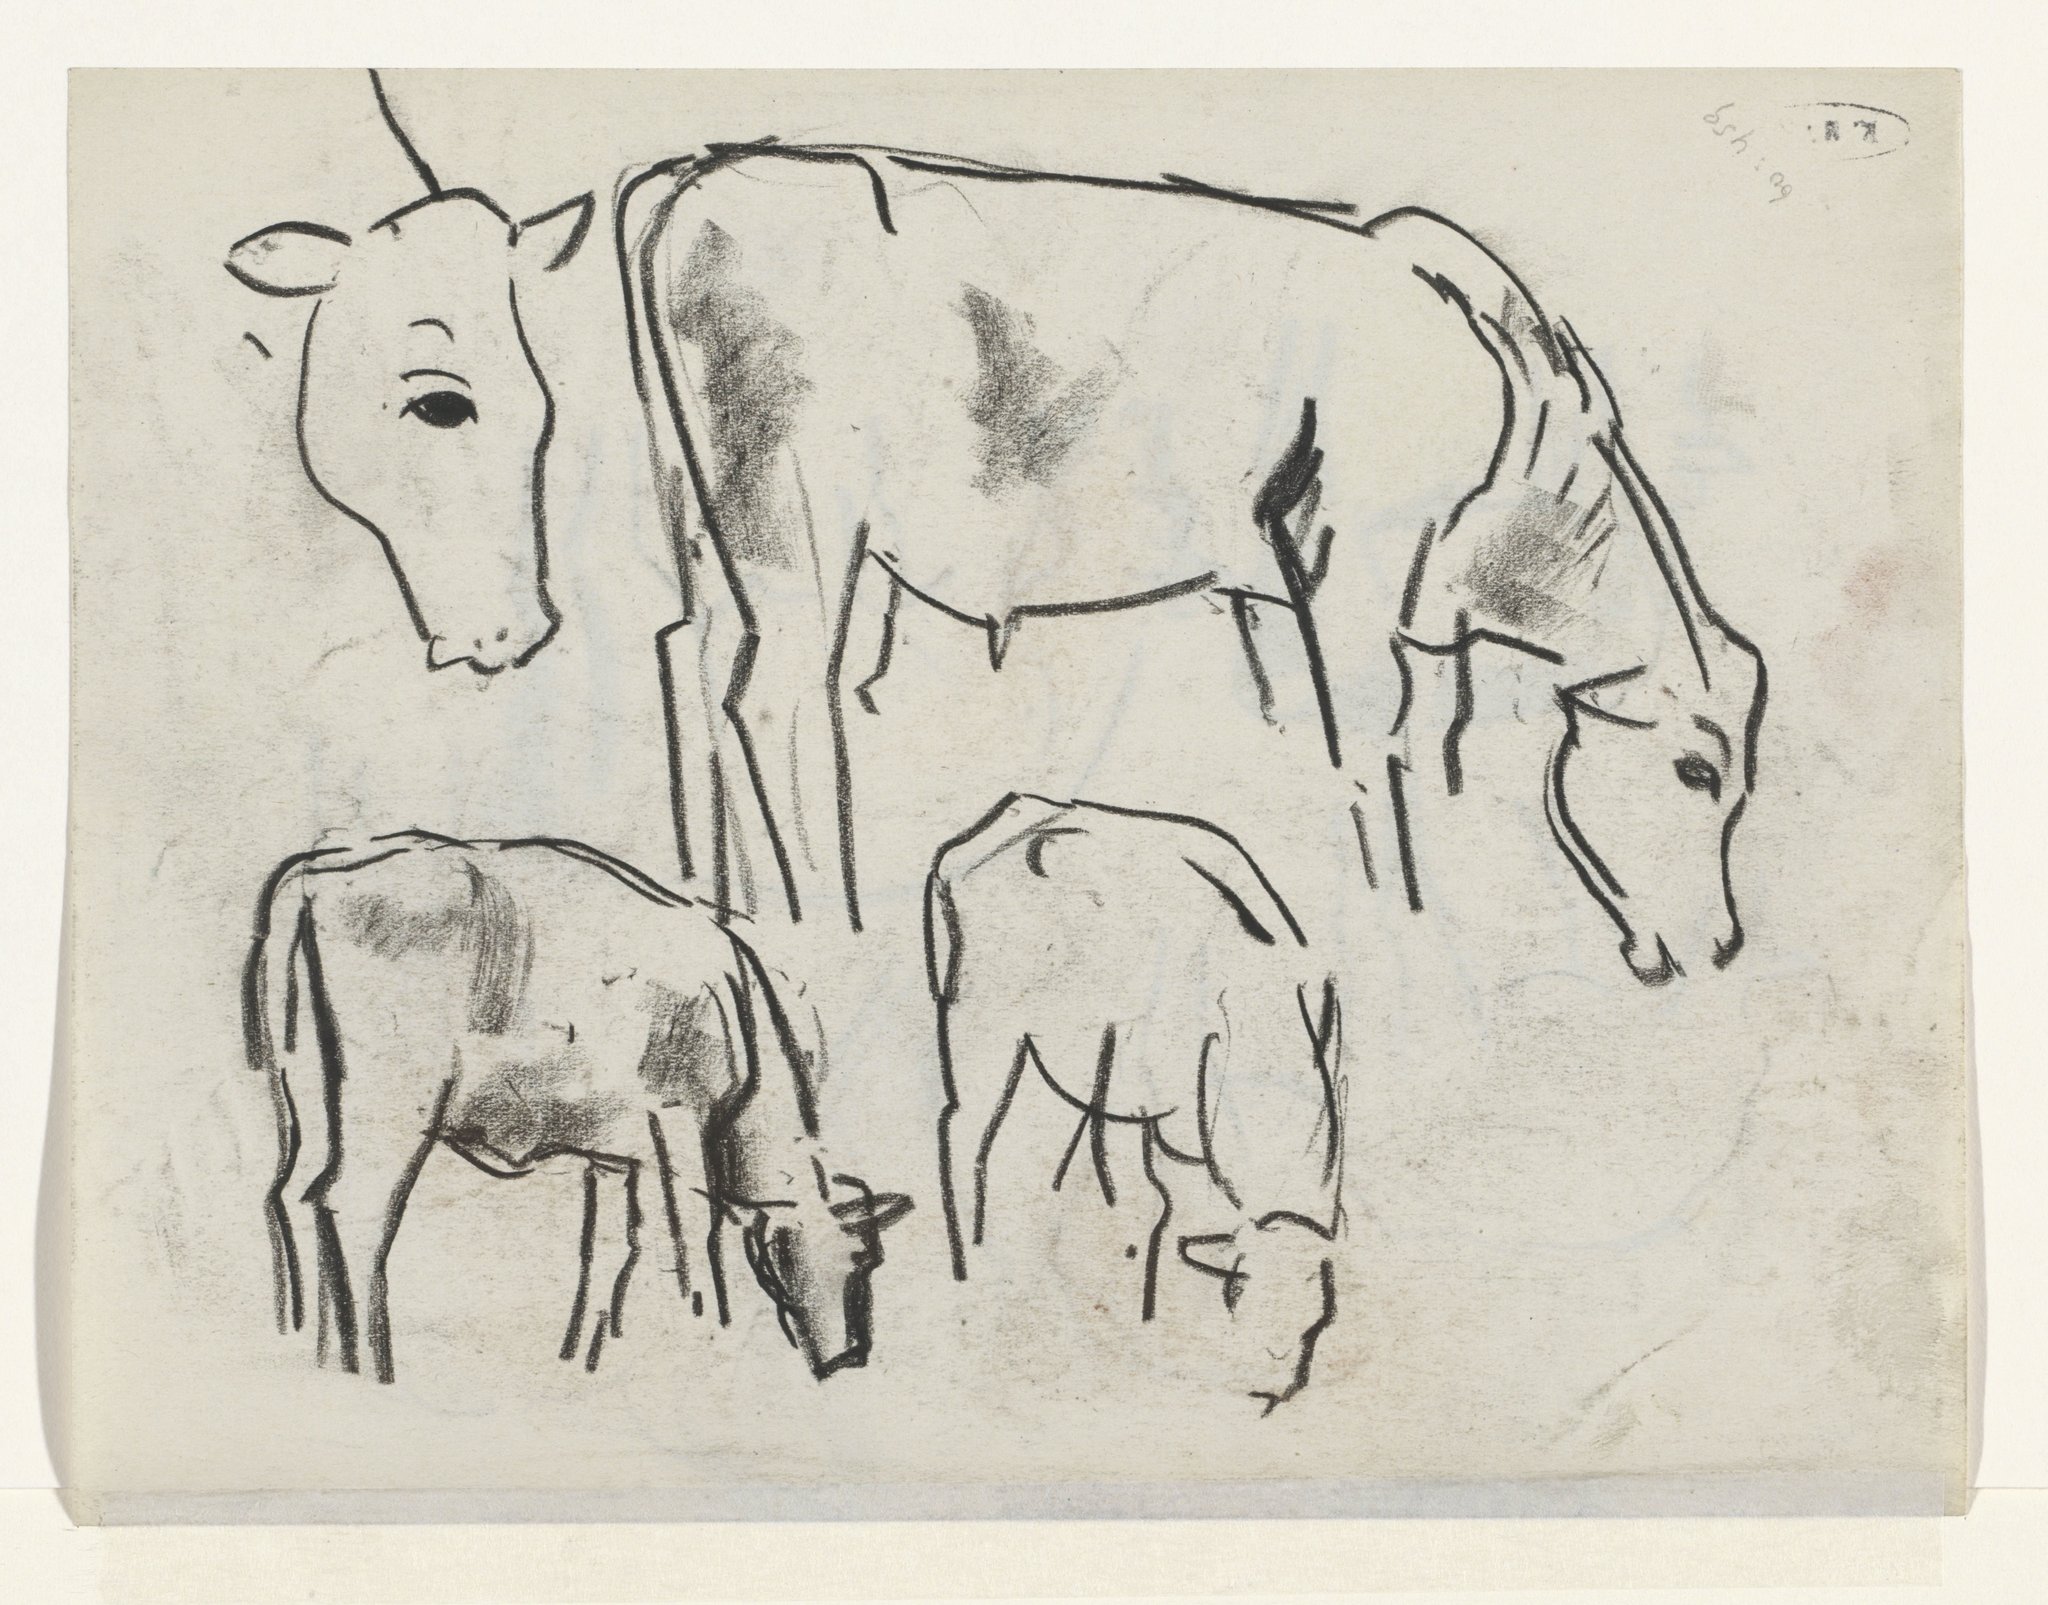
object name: drawing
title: Drie koeien en een koeienkop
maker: leo gestel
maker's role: draughtsman, print maker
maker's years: 1881-1941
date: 1891-1941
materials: chalk, paper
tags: cow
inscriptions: collector's mark: Lugt 2228